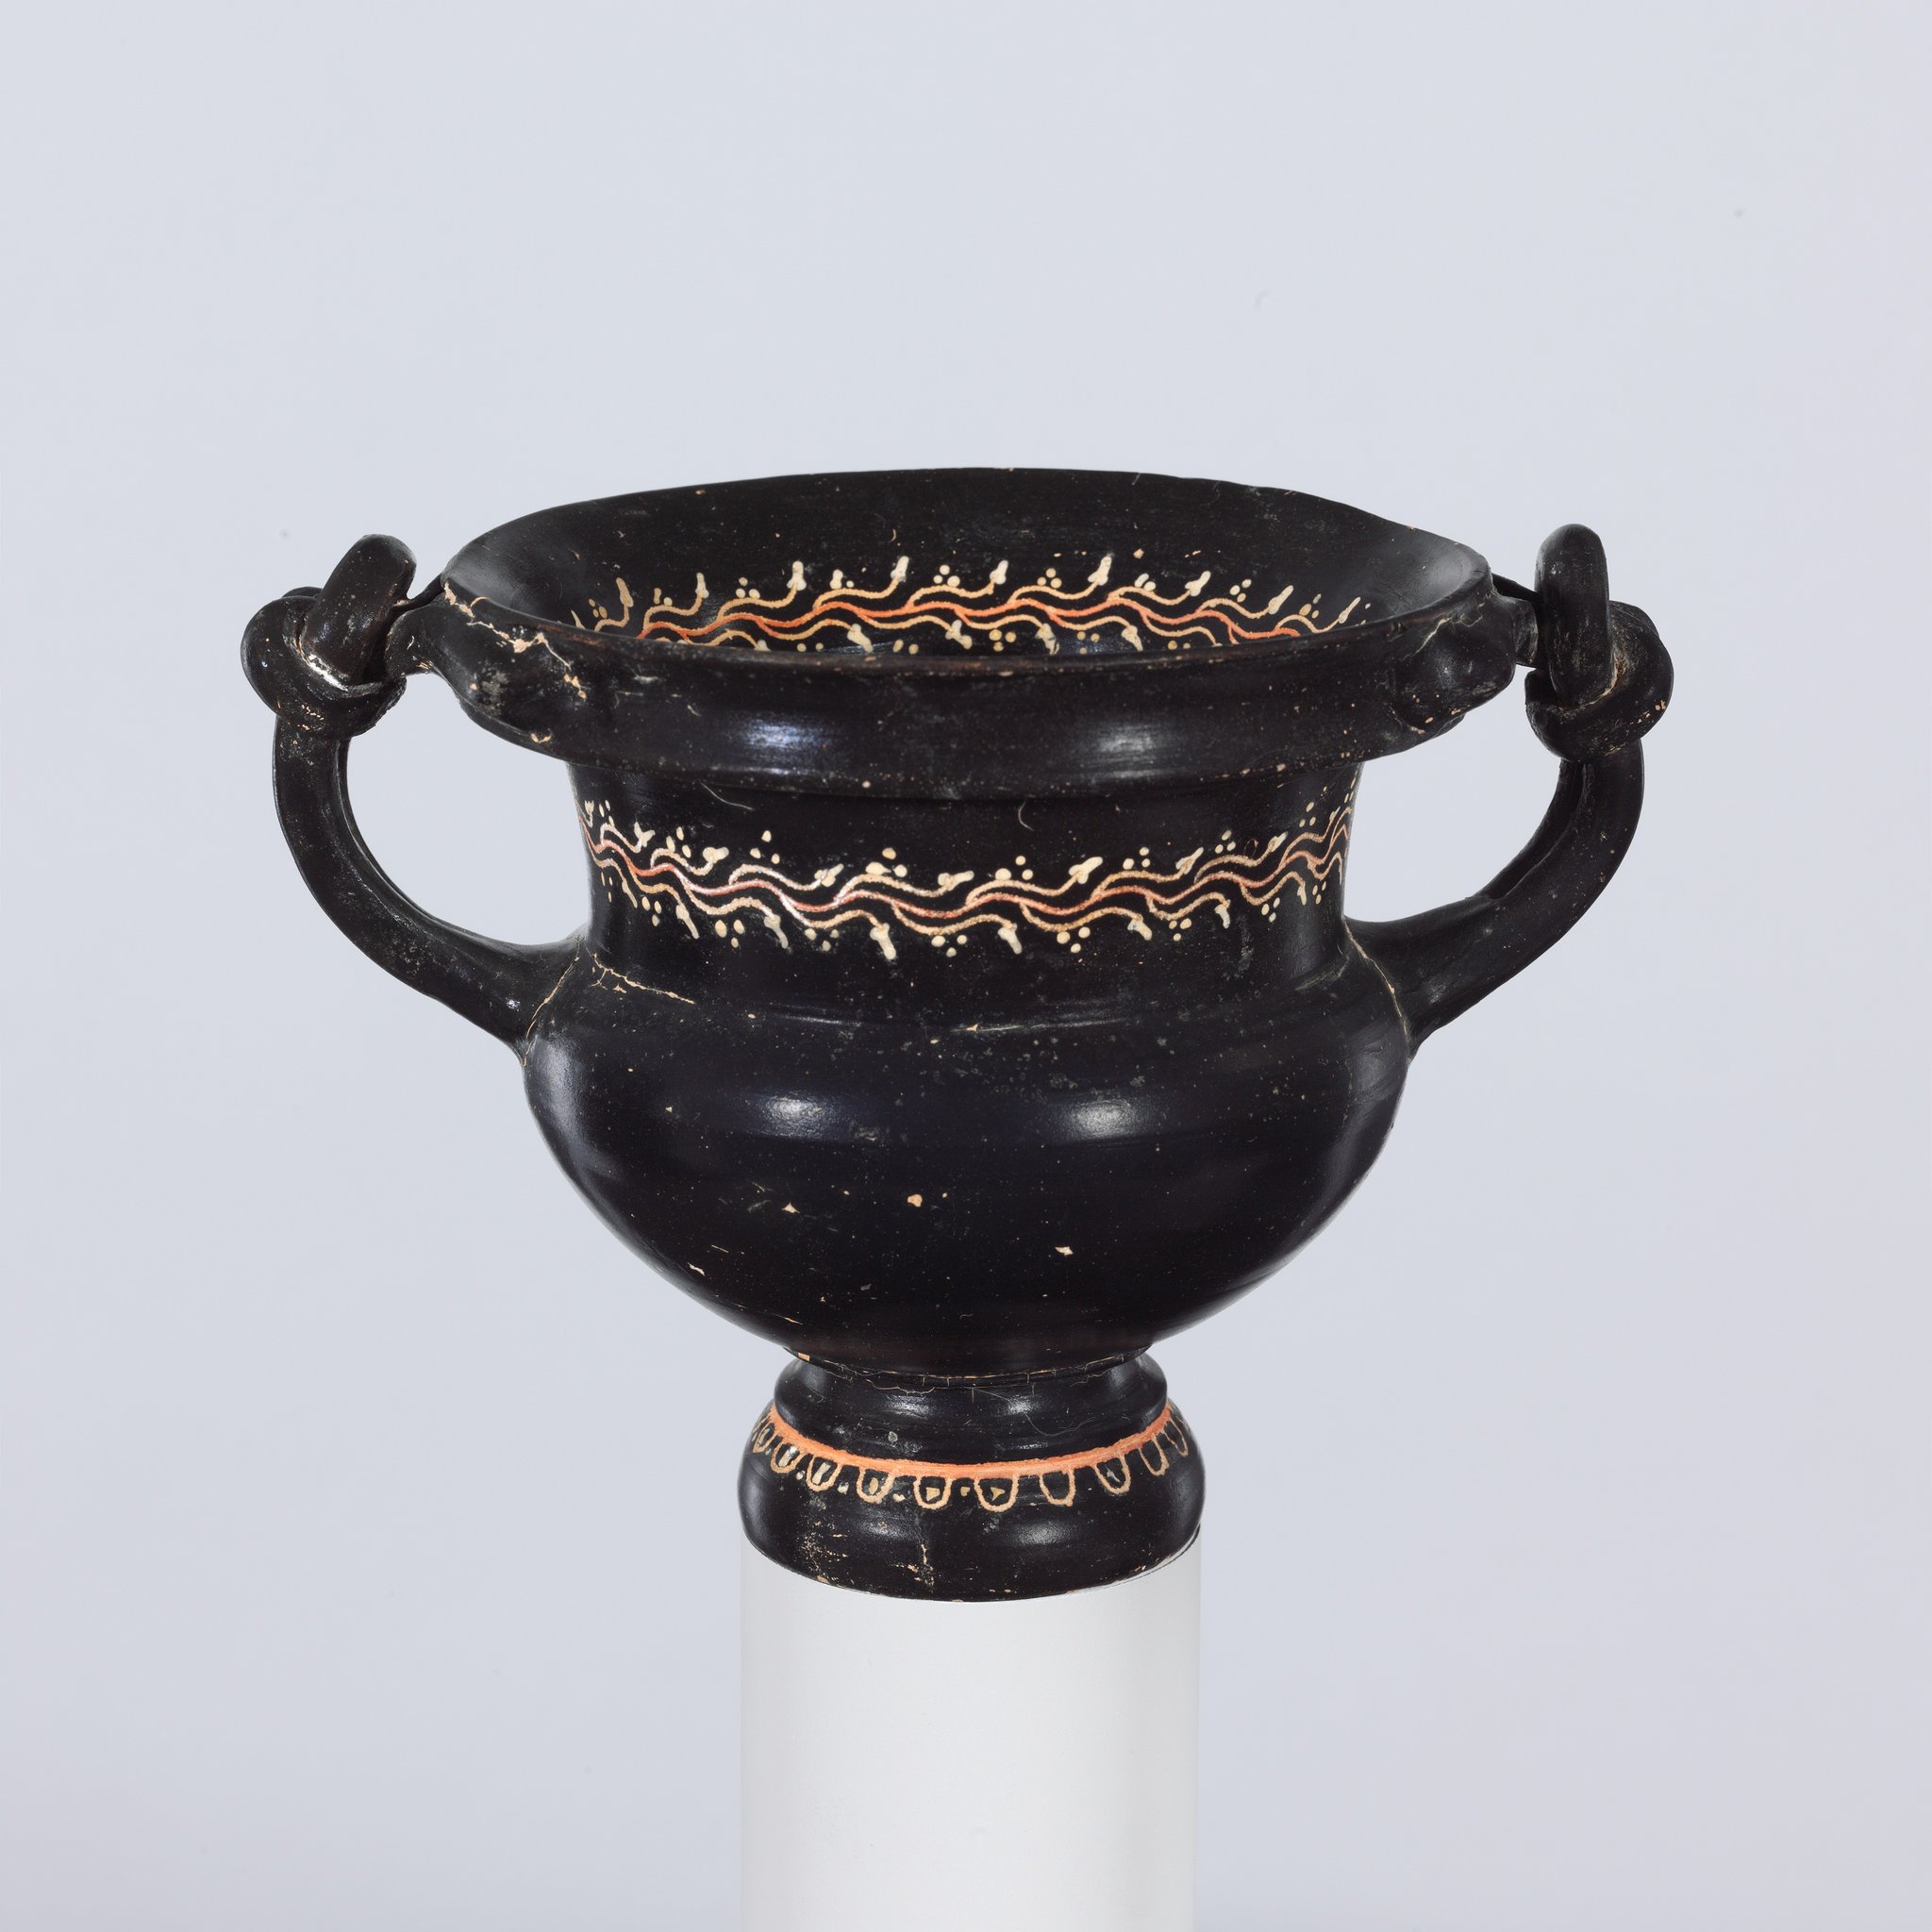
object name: kantharos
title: Terracotta kantharos (drinking cup)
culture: greek, south italian, campanian, teano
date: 330-300 BCE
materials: terracotta